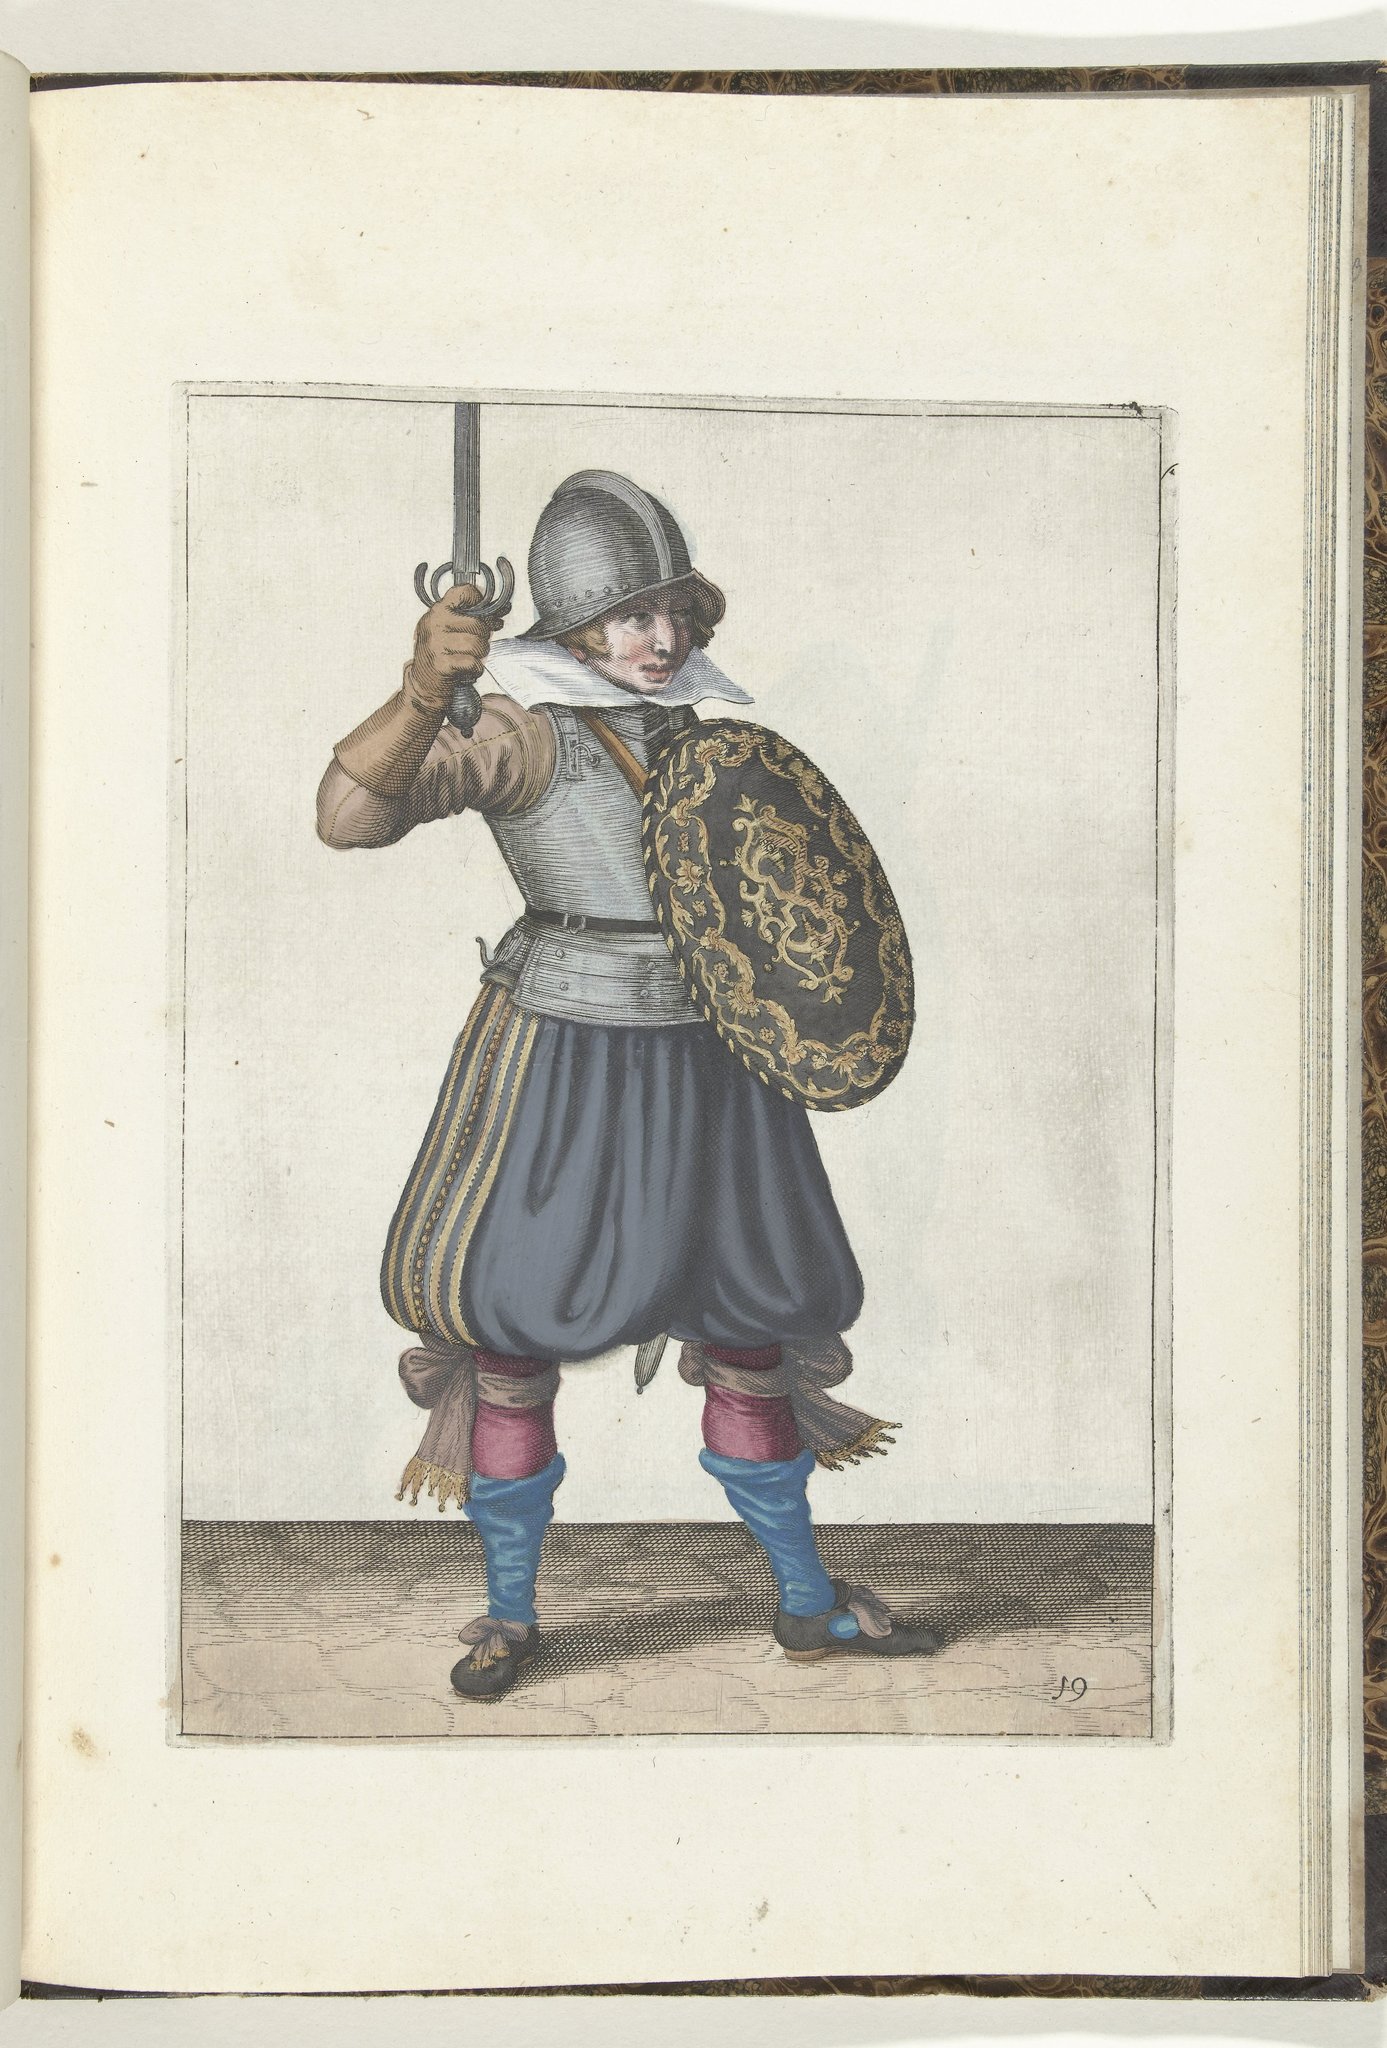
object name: print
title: De exercitie met schild en spies: de soldaat presenteert zijn rapier met de hand niet hoger dan zijn gezicht (nr. 19), 1618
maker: Anonymous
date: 1616-1618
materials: paper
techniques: engraving, hand coloring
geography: northern netherlands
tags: the hague, maurice (prince of orange), handling of weapons ~ military training, weapons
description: Illustratie in: Adam van Breen, Nassauische Waffenhandelung [incompleet exemplaar], 1618?, plaat 19. Dit is een Duitse editie van Adam van Breens De Nassausche Wapen-Handelinge, van Schilt, Spies, Rappier ende Targe : beyde figuerlick afgebeelt, ende gestelt na de nieu ordening [van] ... Maurits van Nassau, 's-Gravenhage, [Aert Meuris] 1618. In het exemplaar in de collectie van de Rijksmuseum Research Library (326 F 23).